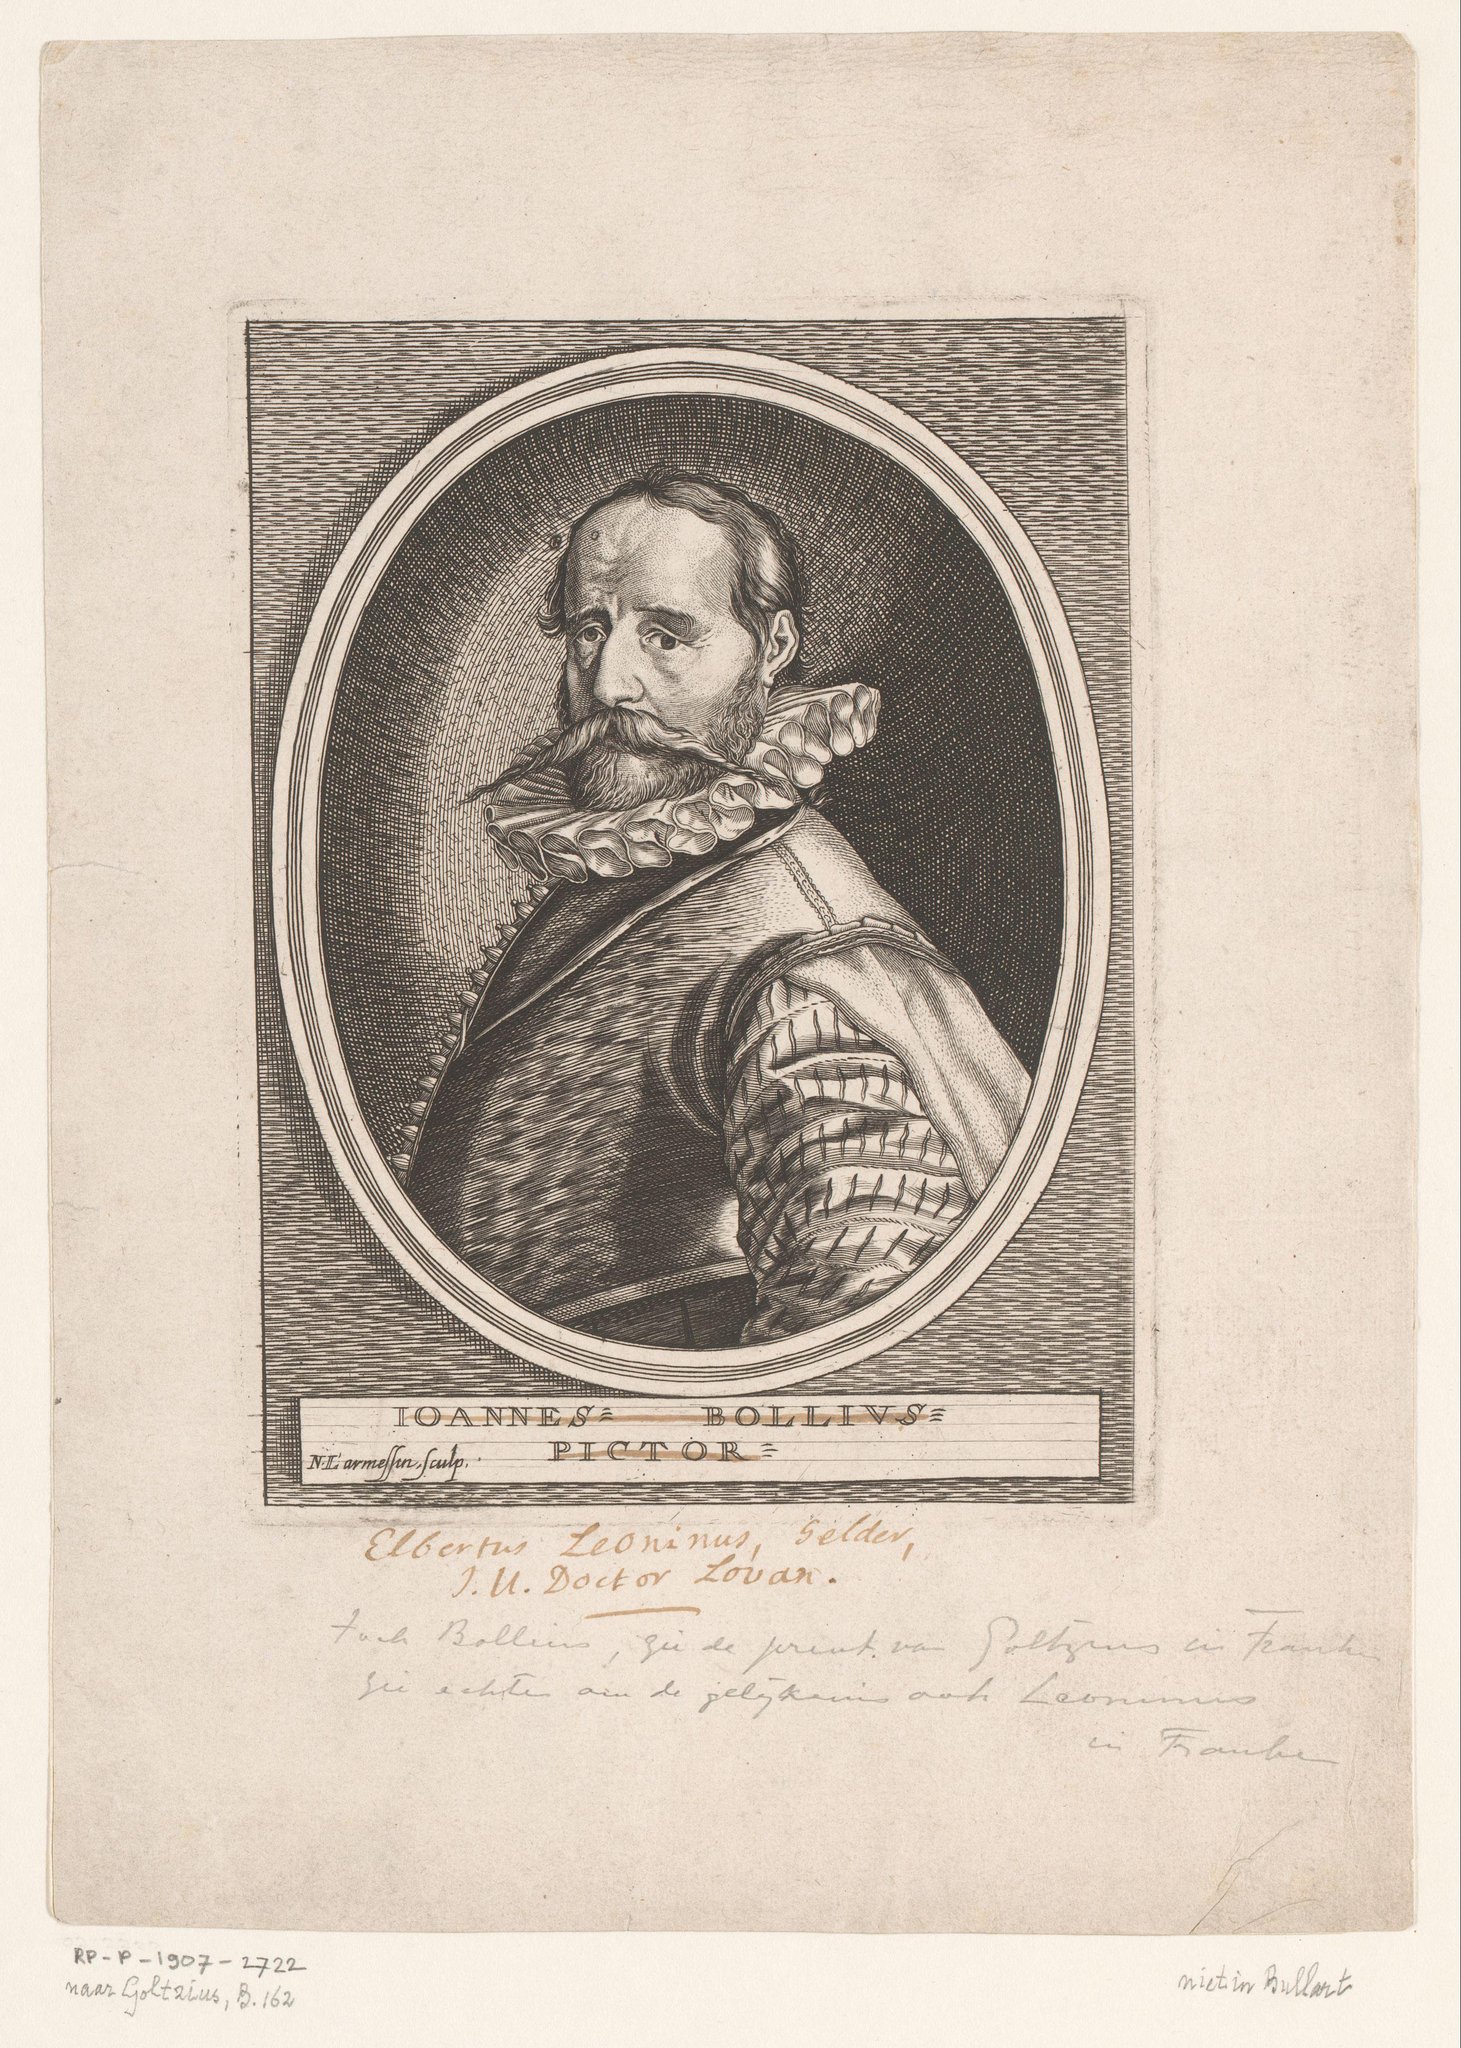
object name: print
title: Iohannes Bollius Pictor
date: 1682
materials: paper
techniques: engraving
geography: brussels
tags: mechelen, amsterdam, print maker, draughtsman, hans bol, historical persons, portrait, self-portrait of artist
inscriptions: collector's mark: Lugt 2228, inscription: ‘Elbertus Leoninus, Gelder/ J.U. Doctor Lovan’, inscription: ‘toch Bollius, zie de prent van Goltzius in Franken (?)/ zie echter [...] de gelijkenis ook Leoninus/ in Franken (?)’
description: Prent waarschijnlijk gebruikt voor: Bullart, Isaac. Académie des Sciences et Arts contenant les vies et éloges his. des hommes illustres qui ont excellé en ces professions depuis environ quatre siècles. Brussel: François Foppens, 1682. Het boek werd in 1682 eveneens in Amsterdam uitgegeven door de erfgenamen van Daniel Elzevier. Ieder portret betreft een illustratie bij de biografie van een kunstenaar of geleerde. De meeste portretten werden door Nicolas de Larmessin vervaardigd (162), 93 door De Boulonois en een derde door ongeïdentificeerde prentmakers.